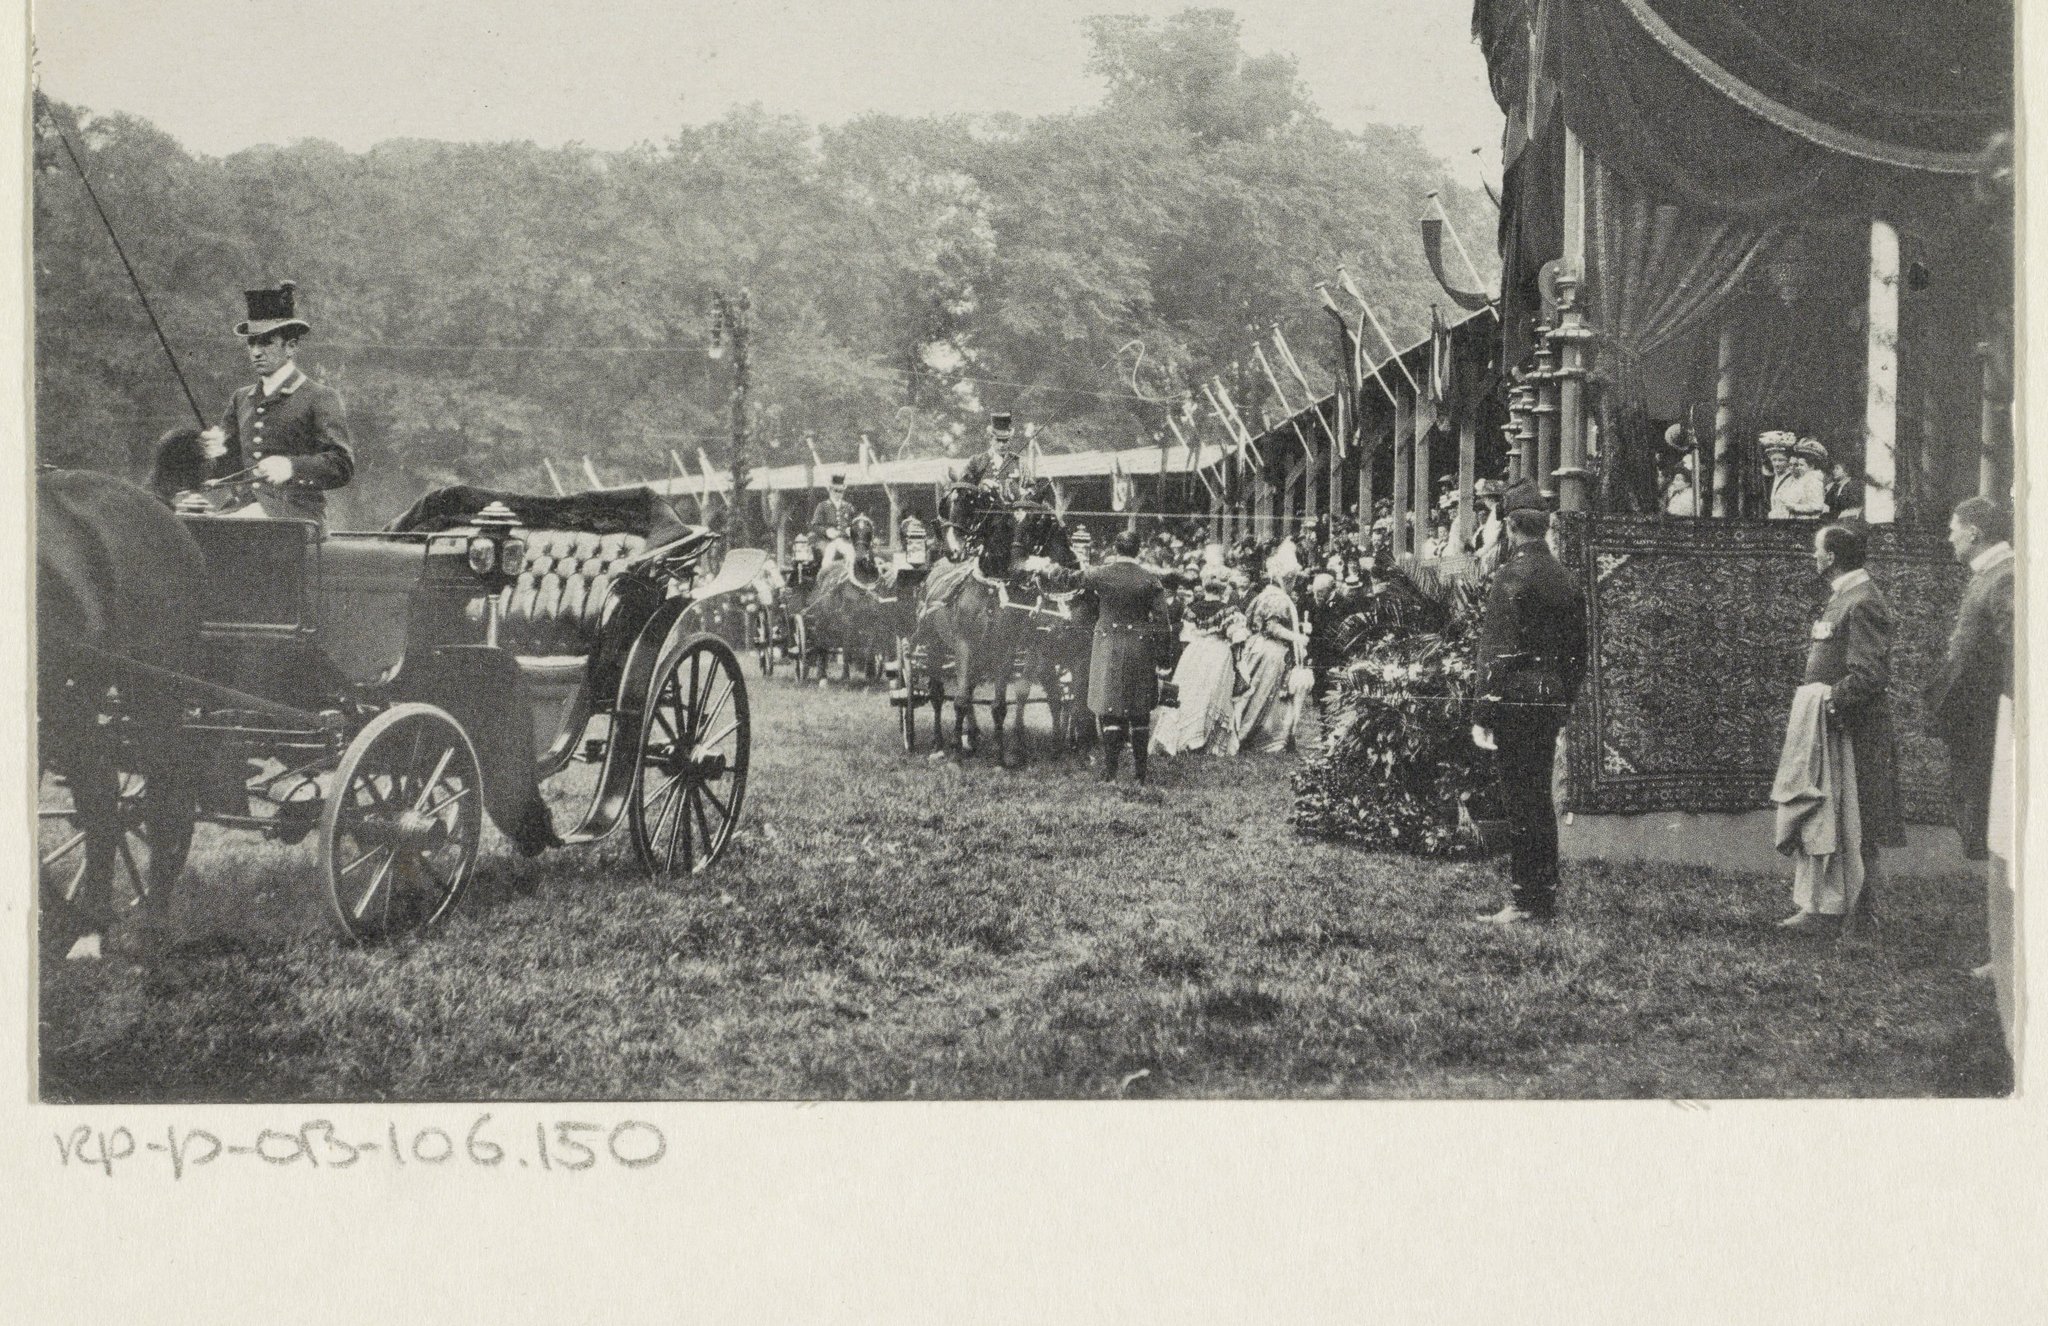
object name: ansichtkaart, prentbriefkaart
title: Aubade ter ere van de geboorte van Juliana, koningin der Nederlanden, te Den Haag op 8 juni 1909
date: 1909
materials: paper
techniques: photograph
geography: the hague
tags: juliana of the netherlands, animal traction, animal-drawn vehicle (carriage etc.), the hague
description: De hier vermelde titel verwijst naar de hoogst verkregen titel van de geportretteerde, niet per se naar de titel die de geportretteerde op deze voorstelling draagt.